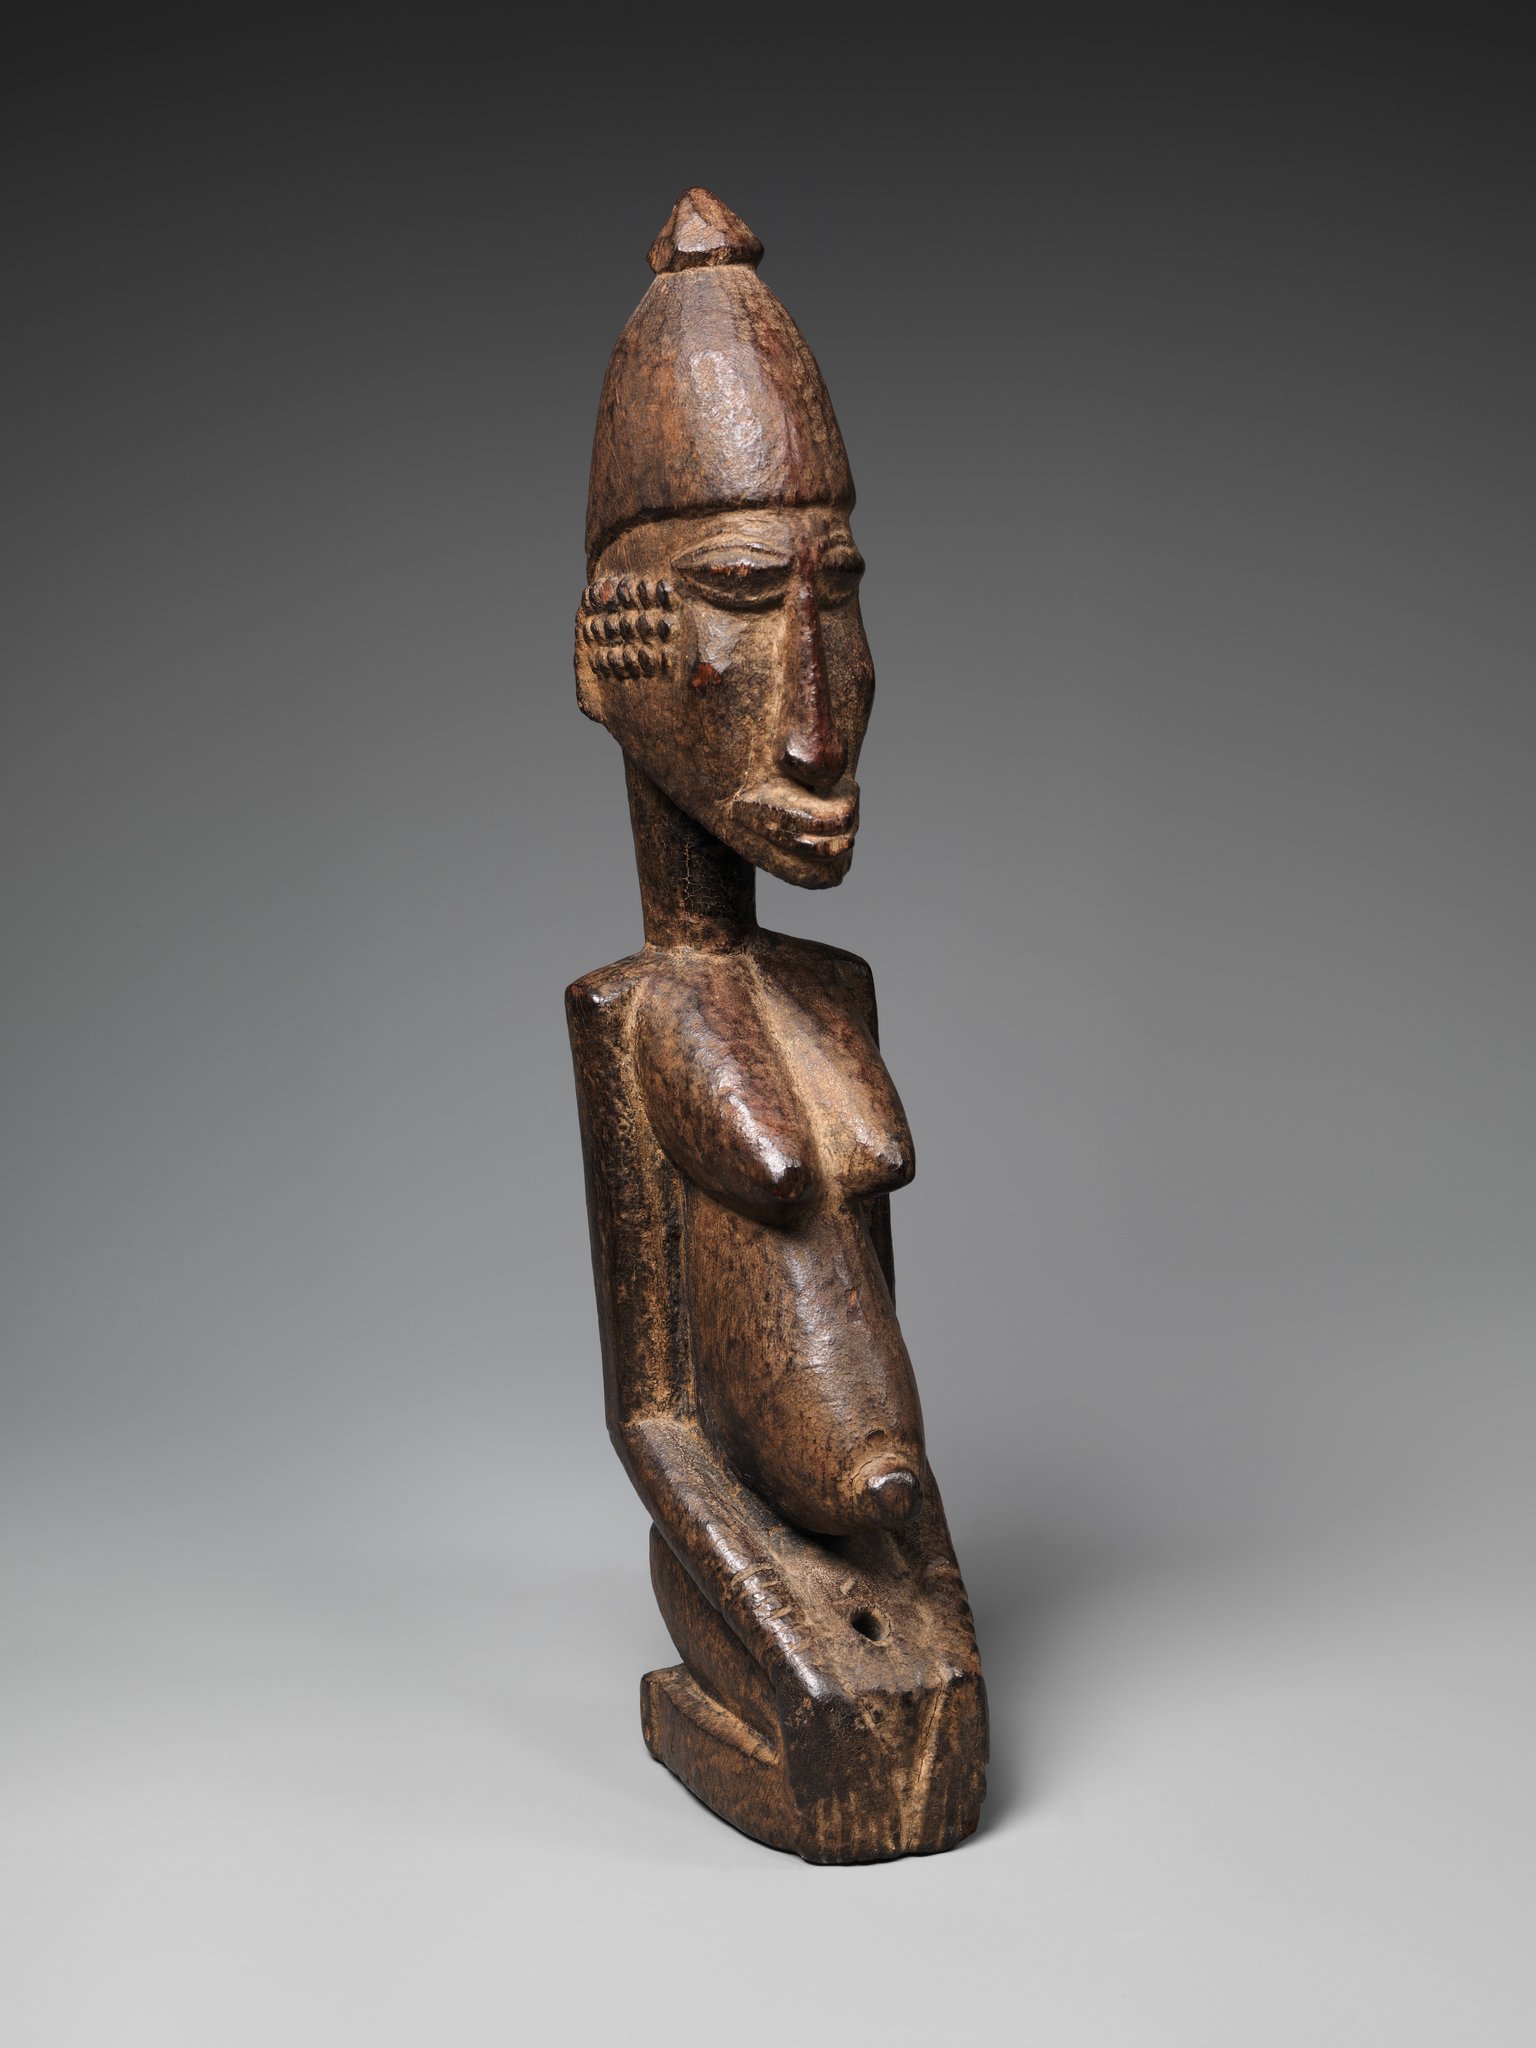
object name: figure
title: Figure of a Kneeling Woman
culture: soninke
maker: soninke blacksmith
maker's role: artist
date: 1500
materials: wood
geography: mali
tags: women